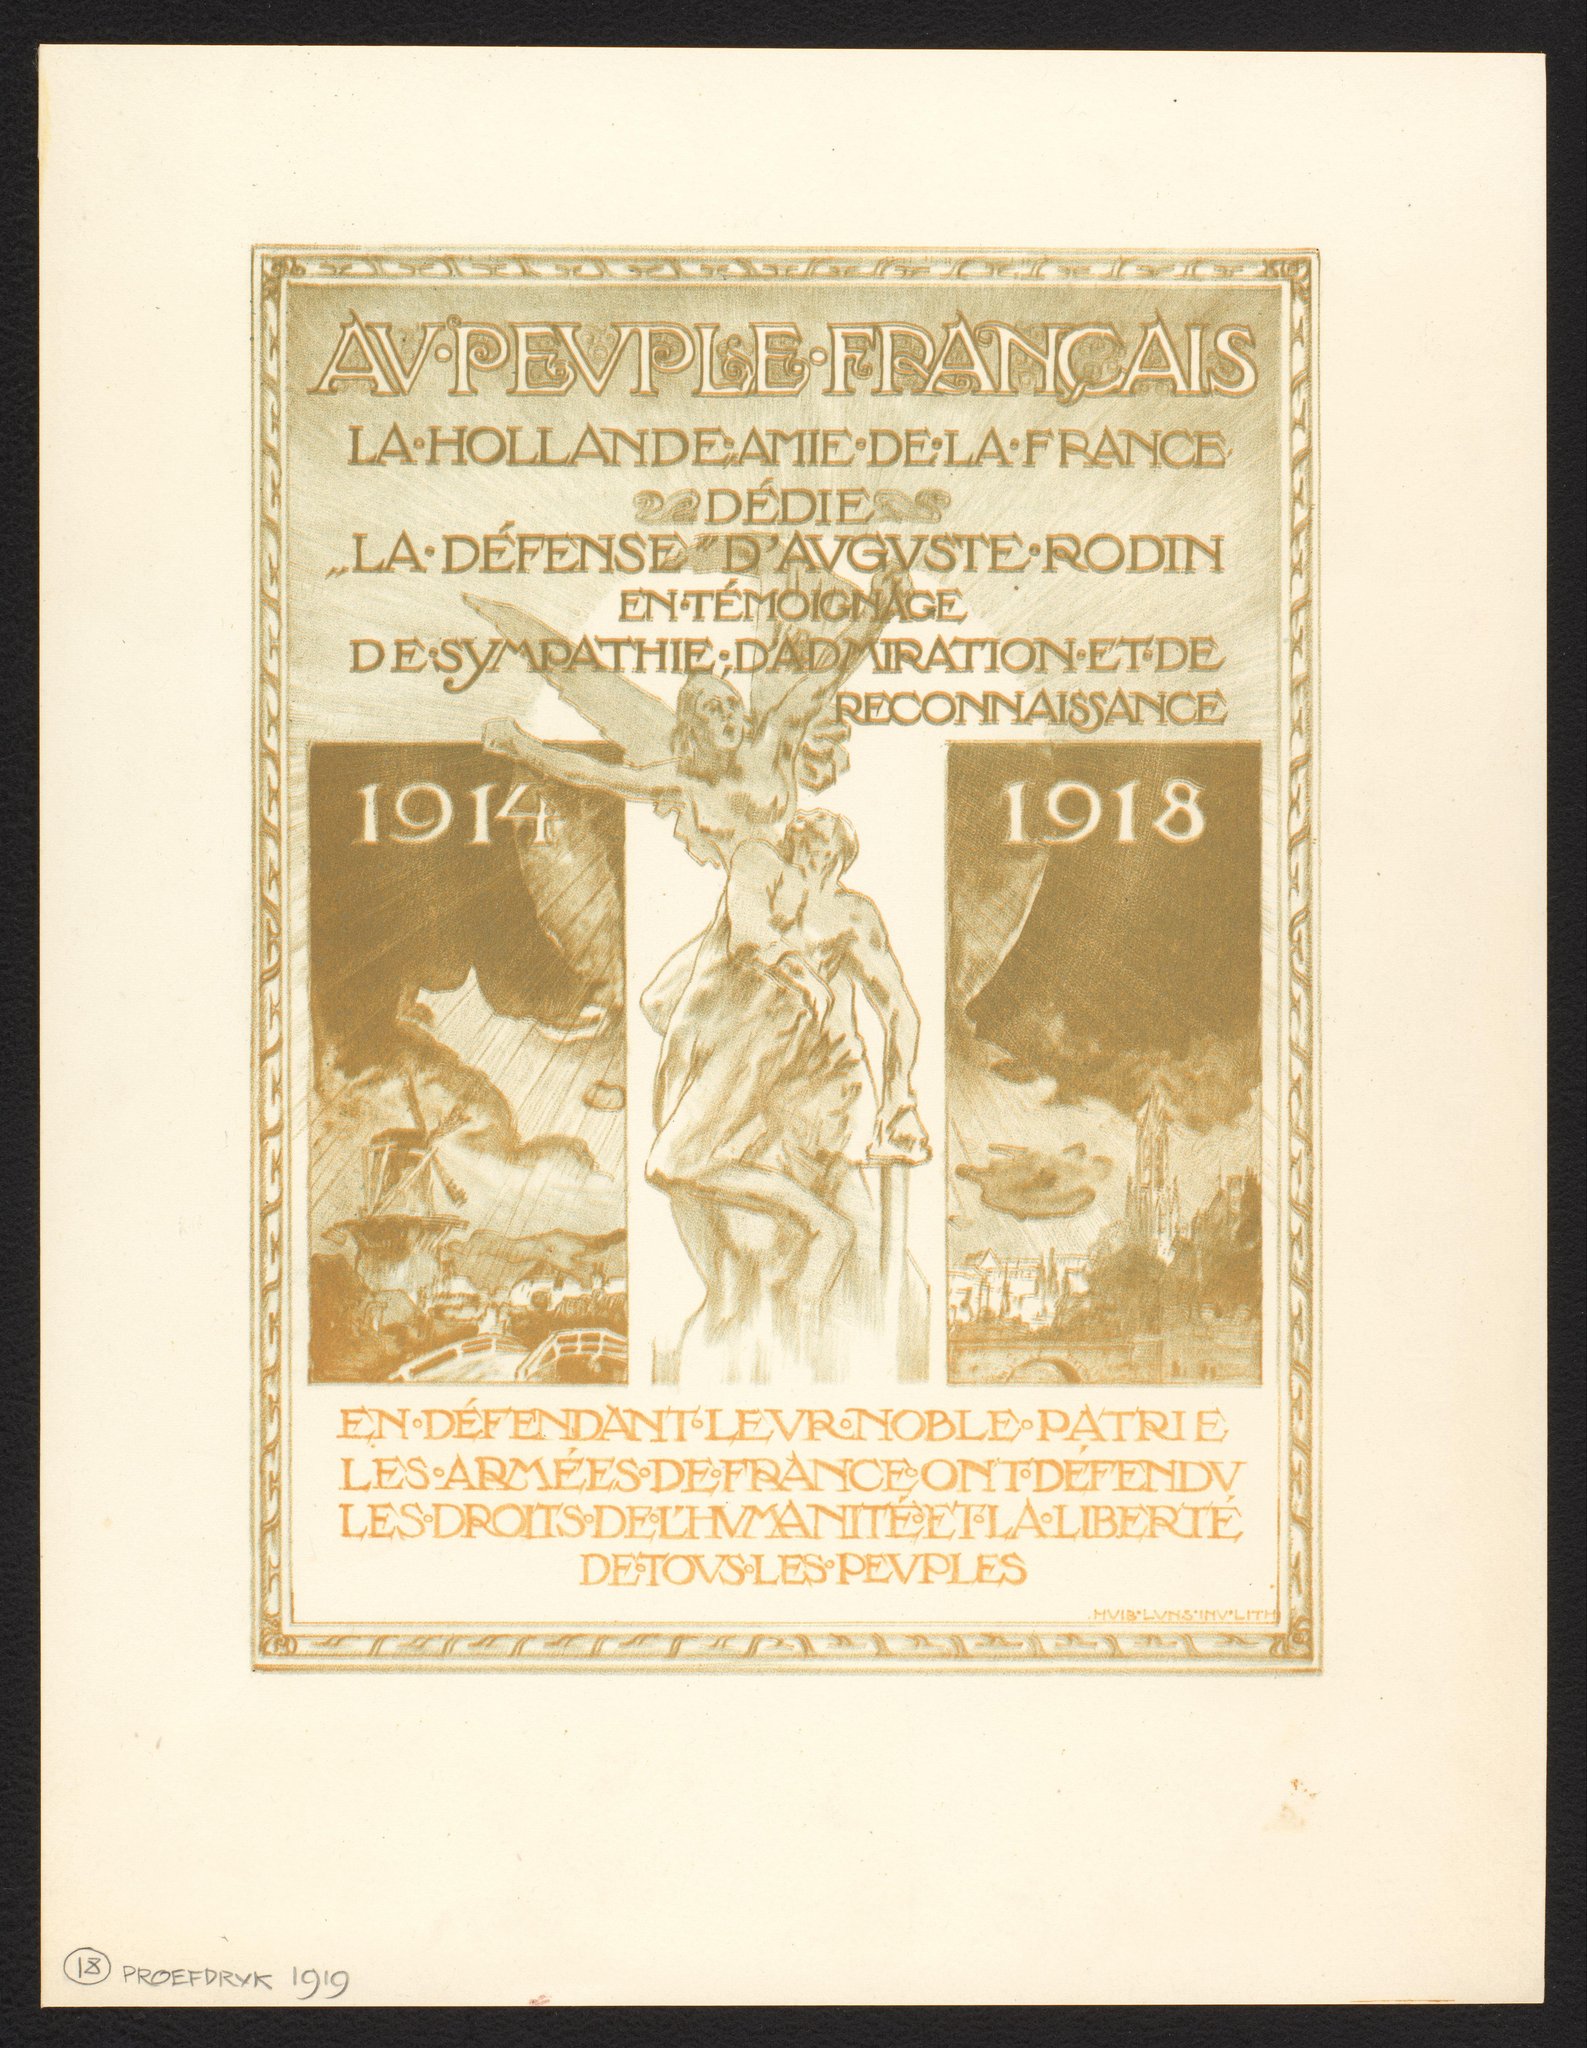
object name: print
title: Affiche bij de schenking van het 'Monument de la Hollande amie' aan Verdun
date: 1919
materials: paper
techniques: lithograph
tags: symbols, allegories of peace, 'pax'; 'pace' (ripa), monument, statue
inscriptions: annotation: ‘18 proefdruk 1919’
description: Centraal het beeld 'La Défense' door Auguste Rodin. Links en rechts daarvan landschappen met de jaartallen 1914 en 1918. Daarboven: 'Au peuple Français la Hollande amie de la France dédie 'La Défense' d'Auguste Rodin en témoignage de sympathie, d'admiration et de reconnaissance'. Onder de afbeelding de tekst: 'En défendant leur noble patrie les armées de France ont defendu les droits de l'humanité et la liberté de tous les peuples'.